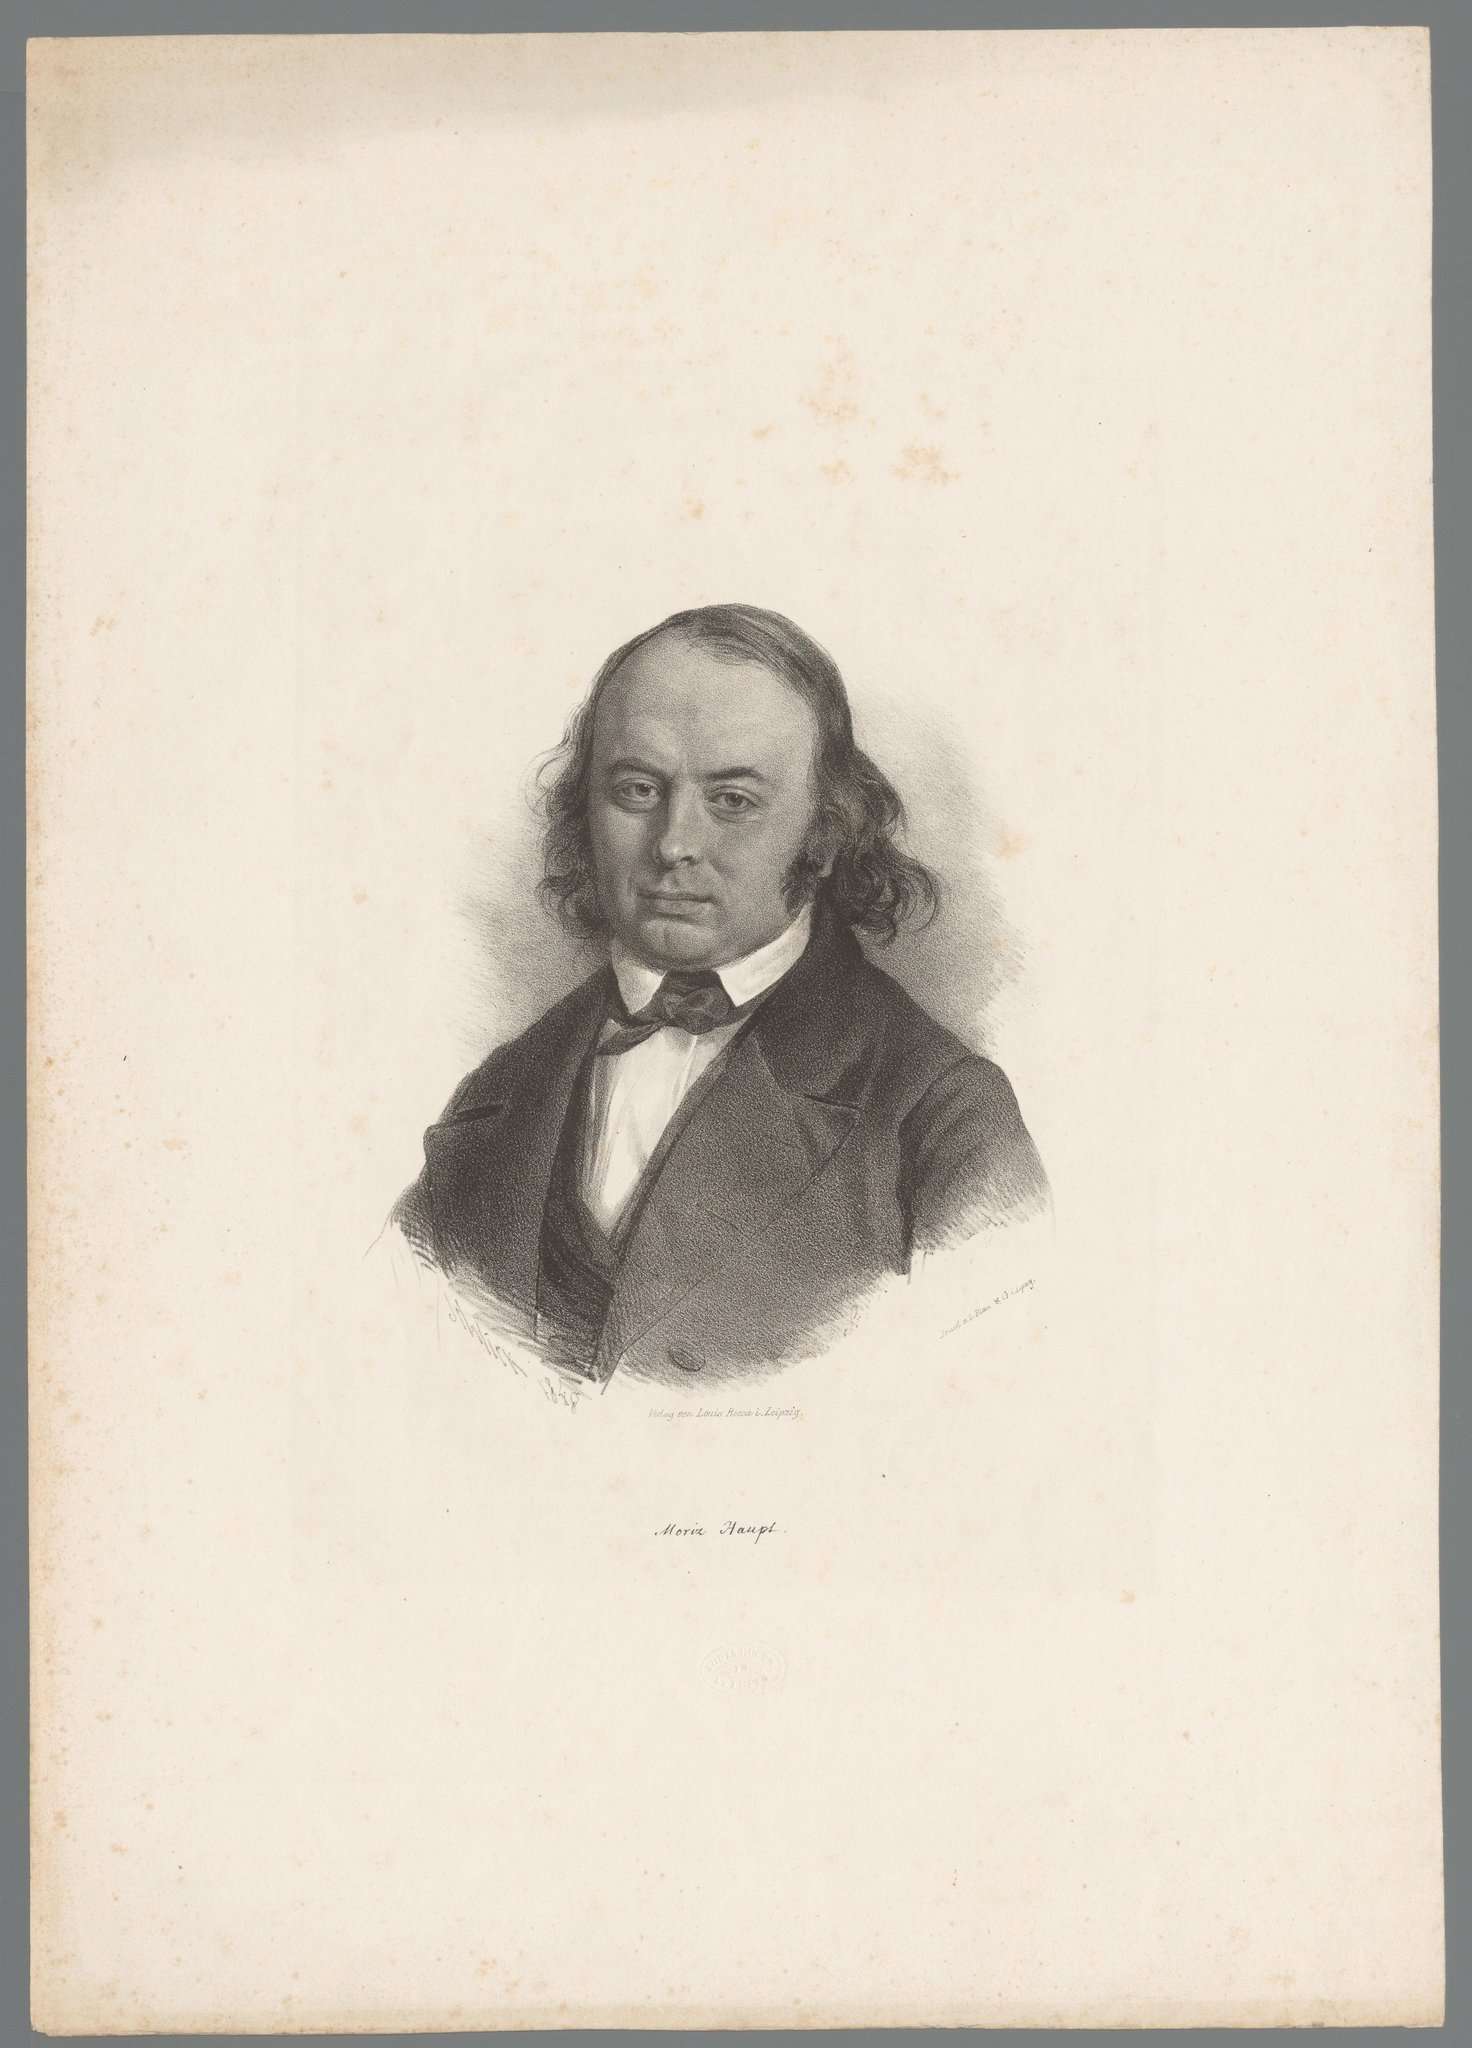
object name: print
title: Portret van Moriz Haupt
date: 1848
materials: paper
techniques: lithograph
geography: leipzig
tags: berlin, philology (+ portrait of scholar, scientist), historical persons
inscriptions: collector's mark: Lugt 2228, check stamp: ‘Louis Rocca in Leipzig’